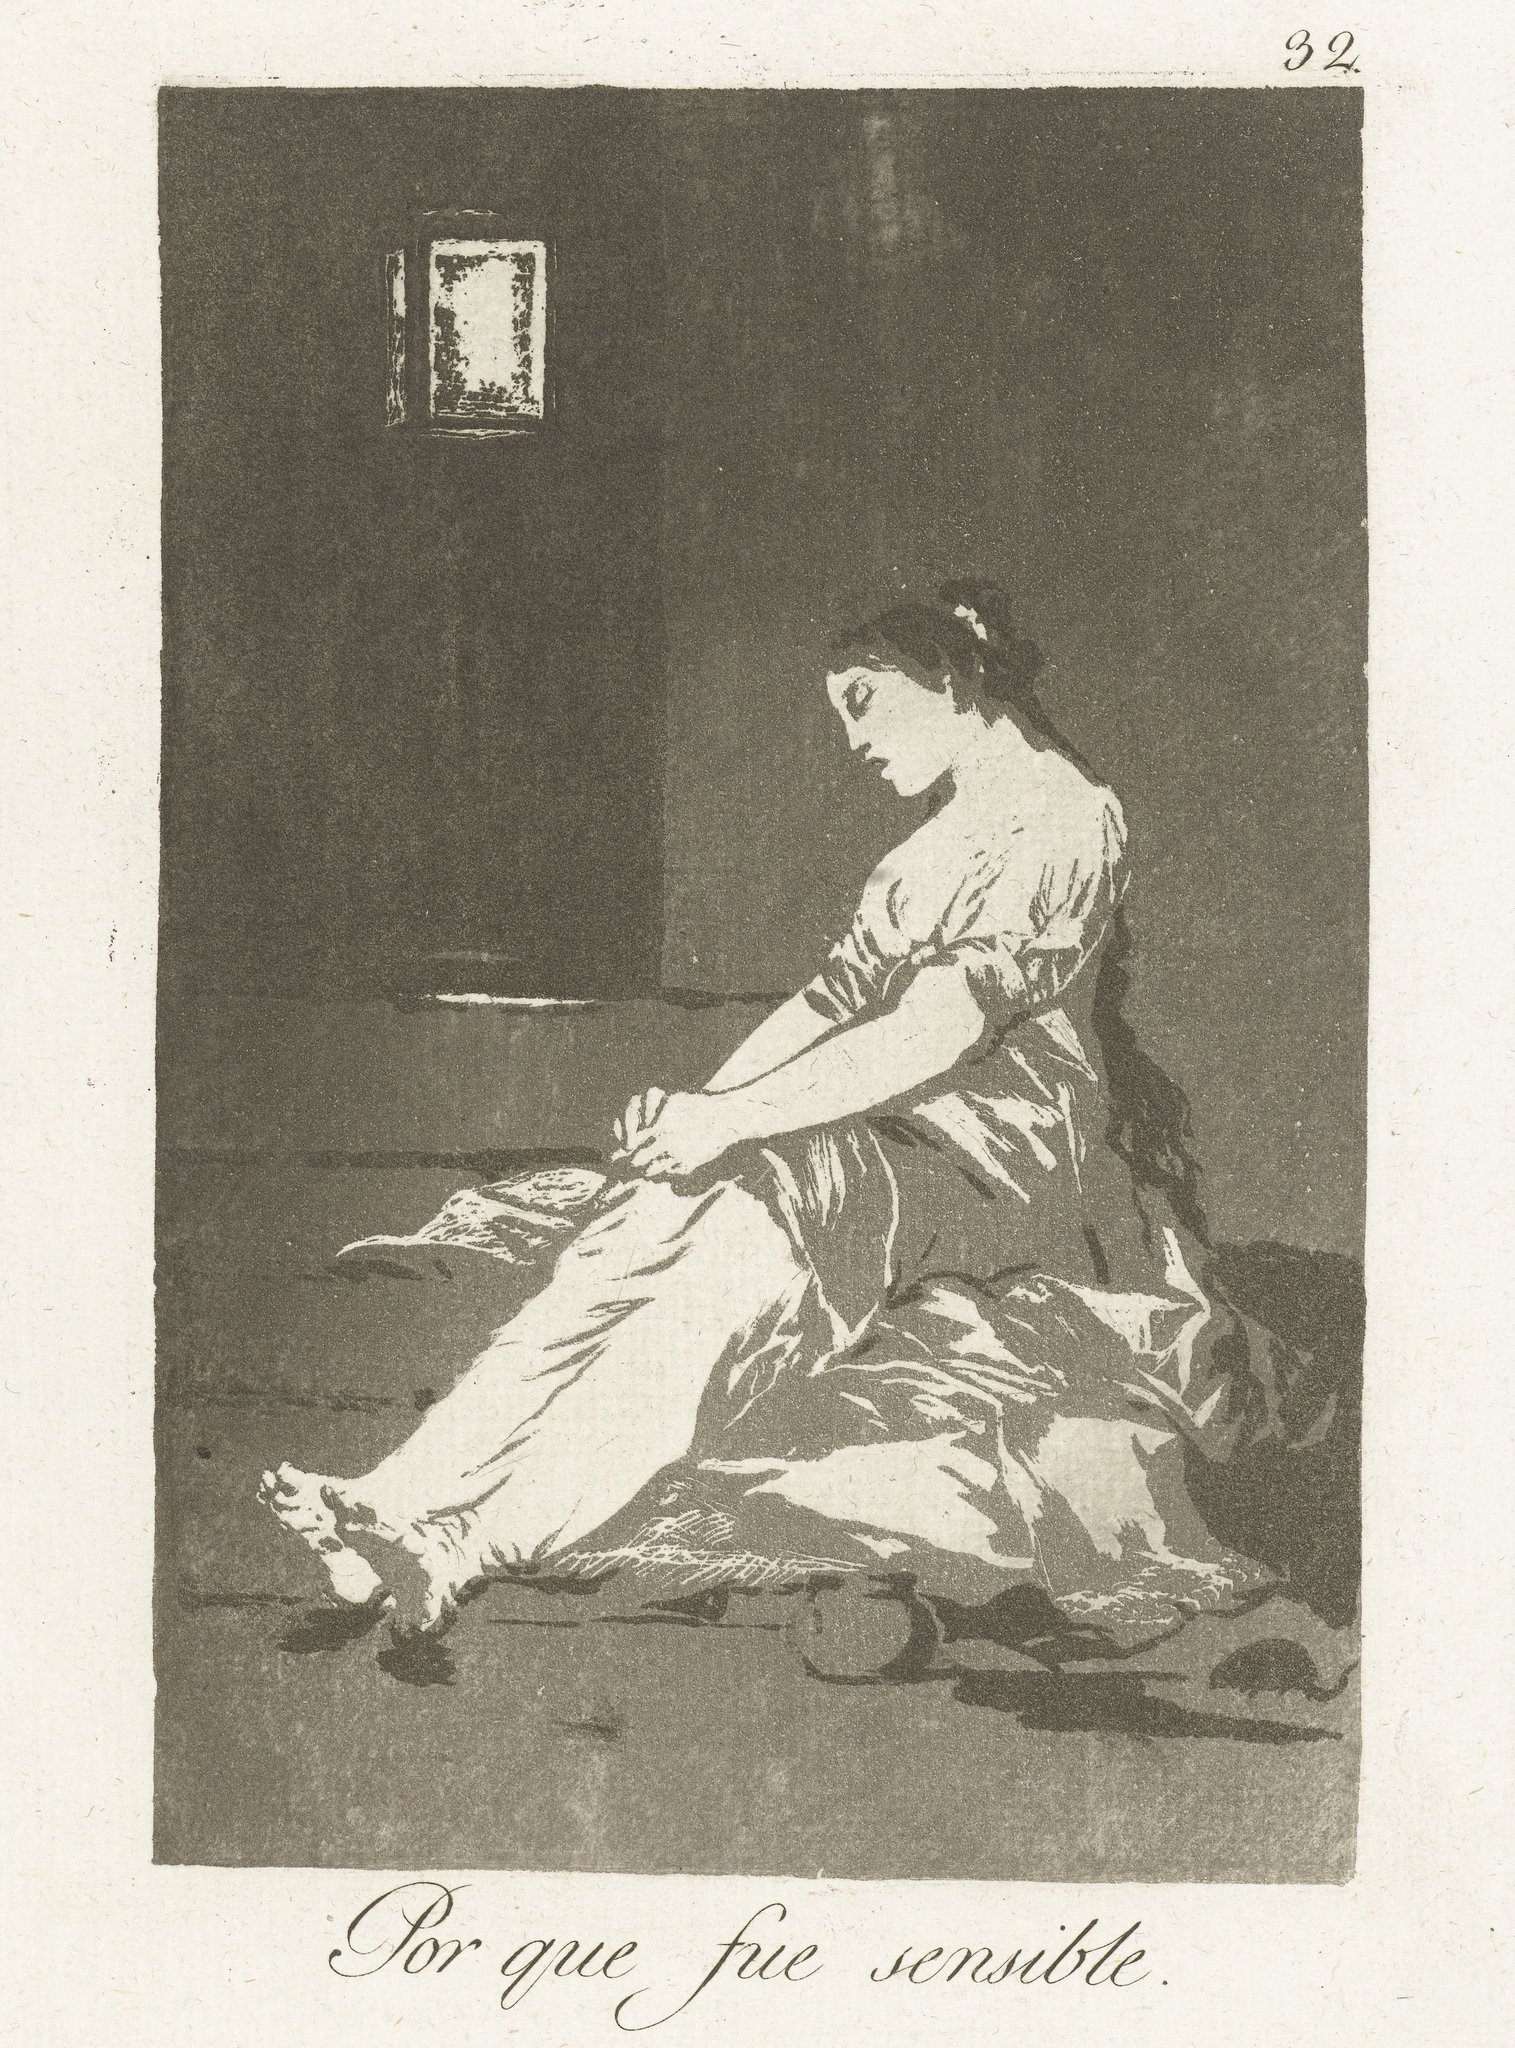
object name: print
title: Los Caprichos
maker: francisco de goya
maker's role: draughtsman, painter, print maker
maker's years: 1746-1828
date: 1797-1799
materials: paper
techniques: aquatint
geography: spain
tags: imprisonment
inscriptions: collector's mark: Lugt 2228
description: Een jonge vrouw, zittend op de grond in een gevangeniscel. Tweeëndertigste prent uit de serie Los Caprichos.